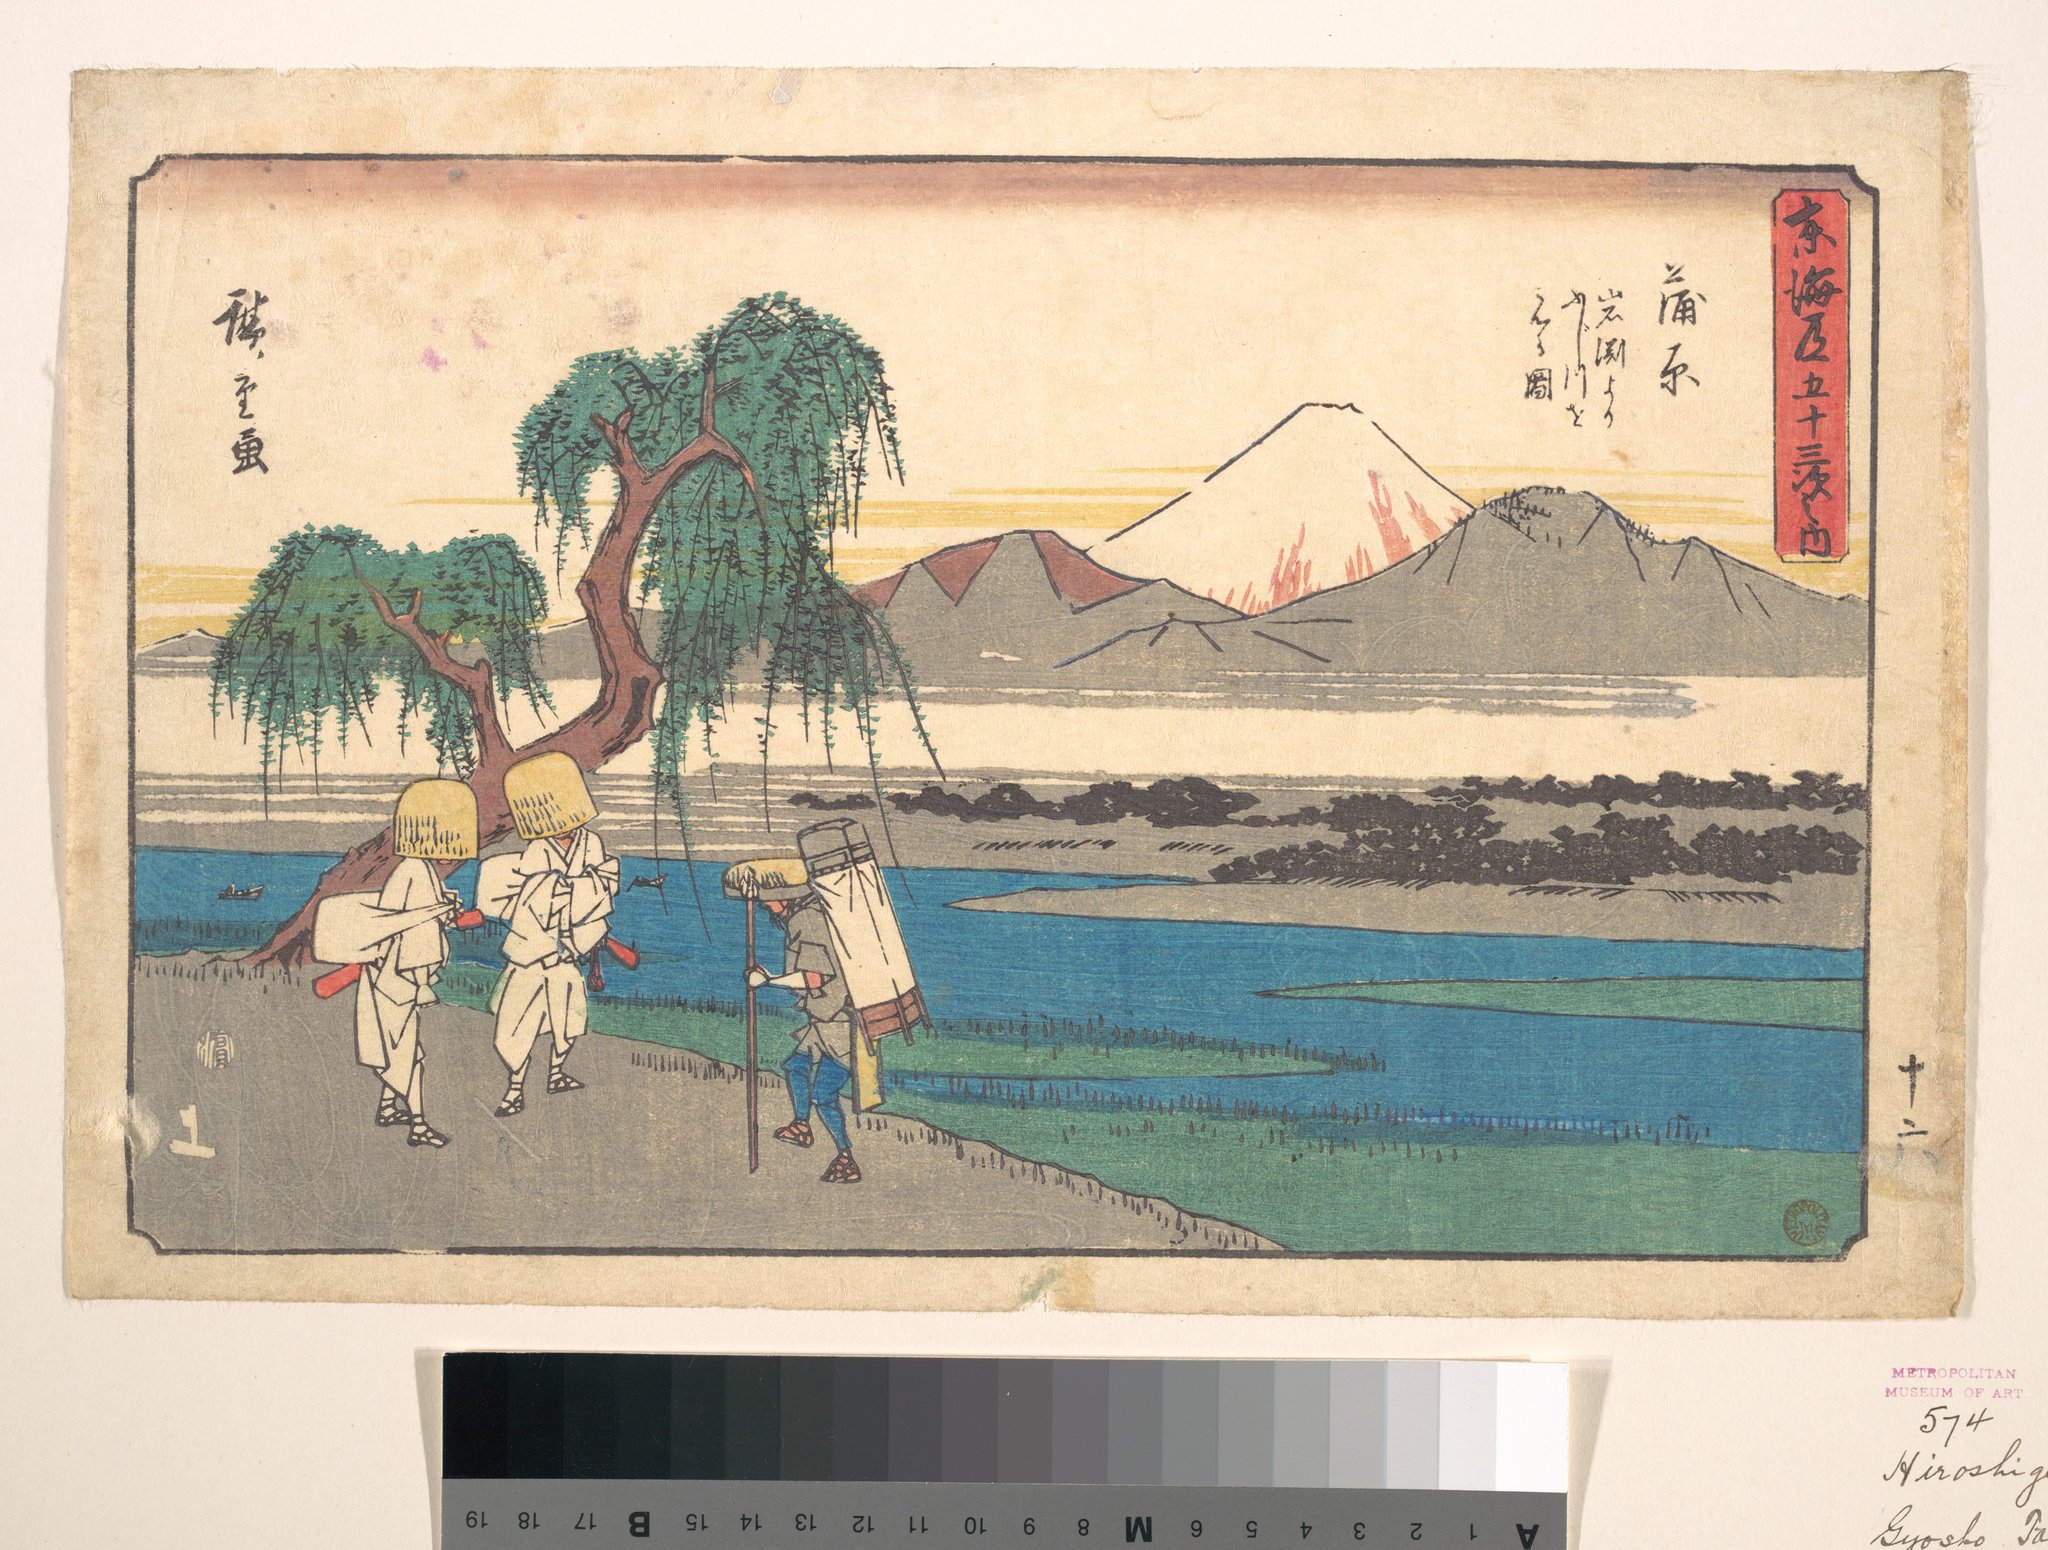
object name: print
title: Kambura Station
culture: japanese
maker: utagawa hiroshige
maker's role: artist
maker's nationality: japanese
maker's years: 1797-1858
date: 1842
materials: ink, paper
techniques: woodblock print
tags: human figures,mountains,landscapes